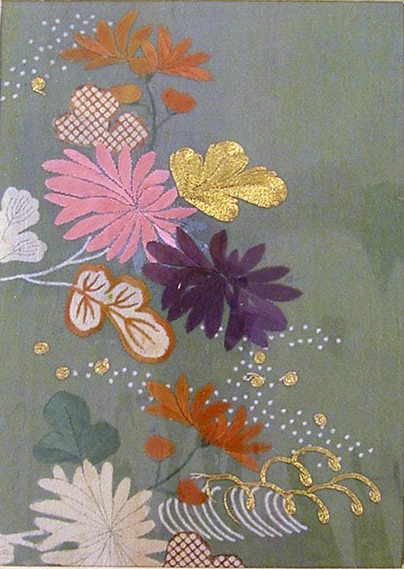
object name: piece from a kosode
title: Piece from a Kosode with Chrysanthemums and Waves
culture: japanese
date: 1615-1868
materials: metal thread, silk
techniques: dyeing, embroidery, painting, weave, resist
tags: flowers